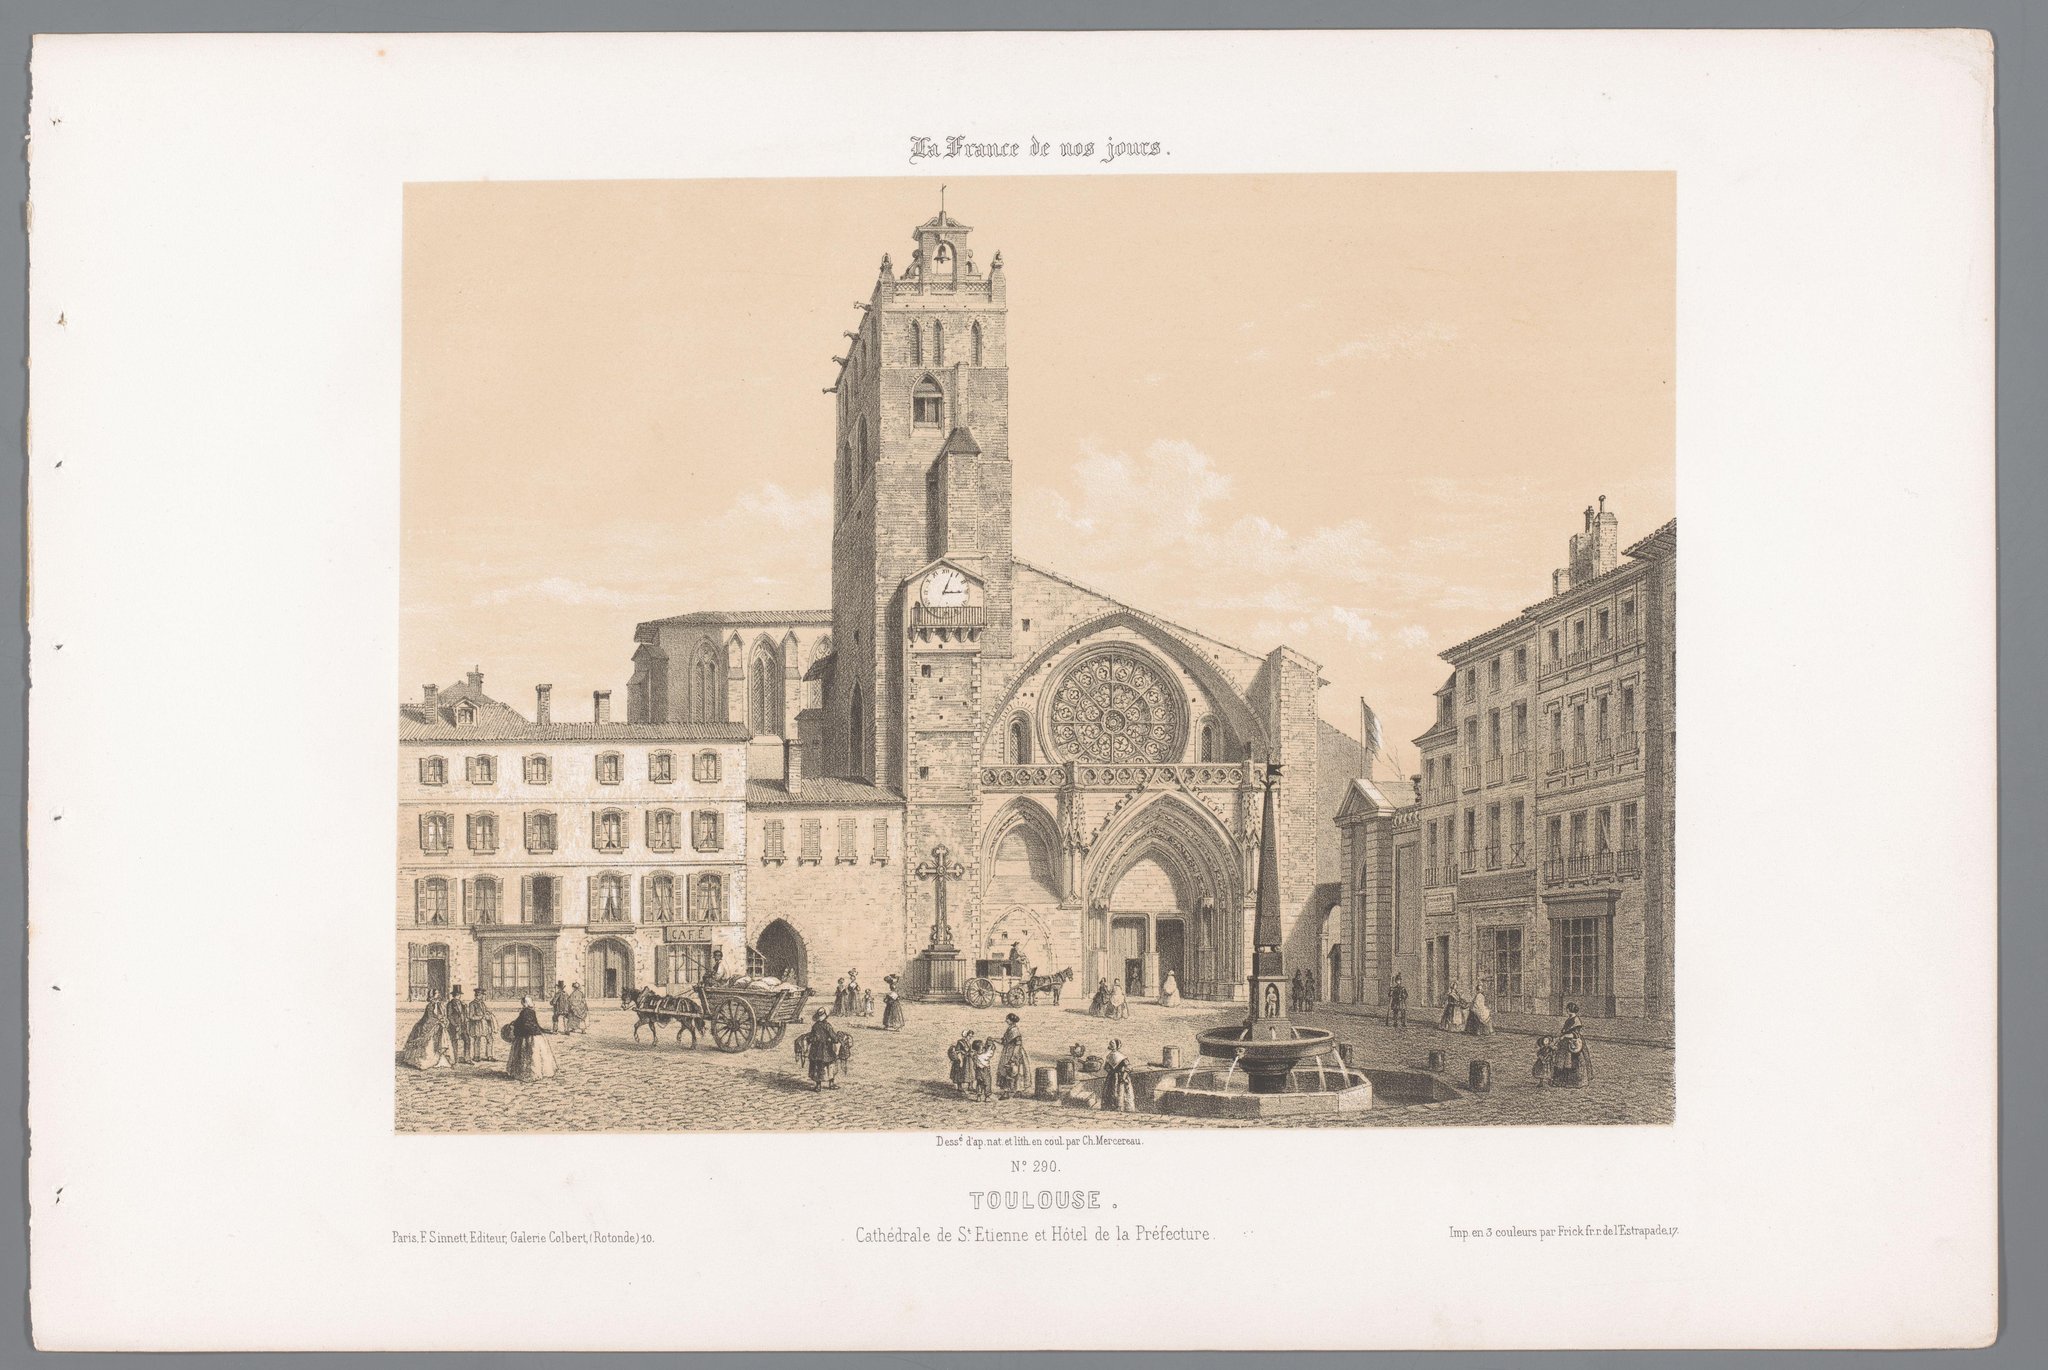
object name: print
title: Gezicht op de Sint-Etiennekathedraal te Toulouse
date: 1856-1874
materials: paper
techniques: tone lithography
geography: paris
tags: city-view, and landscape with man-made constructions, church (exterior), ornamental fountain, hotel, hostelry, inn, village square, place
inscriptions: collector's mark: Lugt 2228